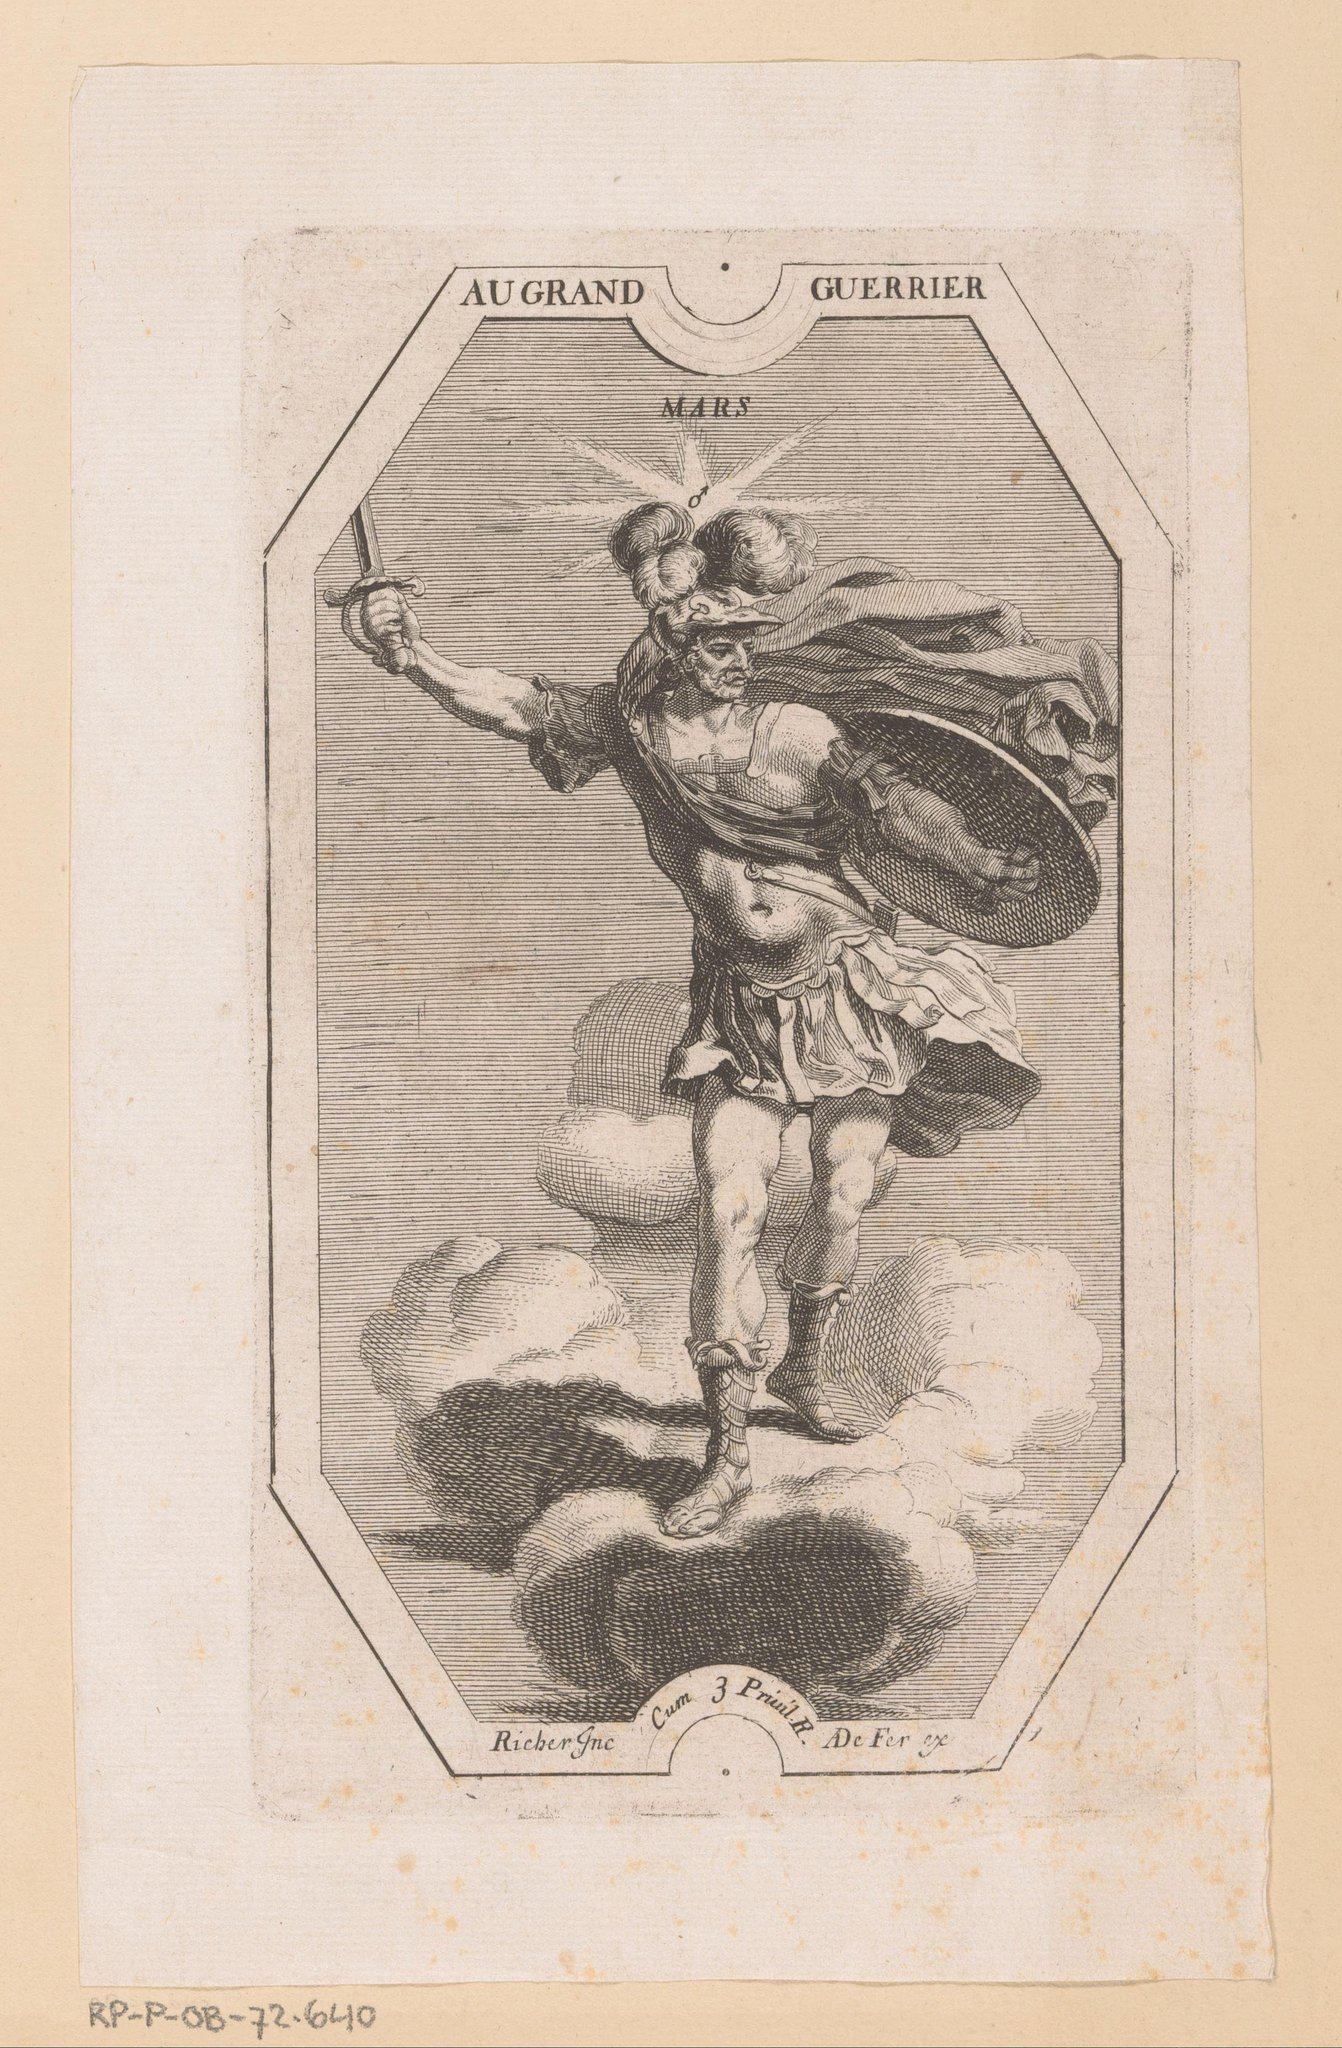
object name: print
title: Au Grand Guerrier Mars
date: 1630-1673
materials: paper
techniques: engraving, etching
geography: france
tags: (story of) mars (ares), planets; planetary system, solar system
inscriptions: collector's mark: Lugt 240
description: Prent maakt deel uit van een serie met in ieder geval zeven genummerde prenten (collectie Rijksmuseum). Dit is nummer 3.